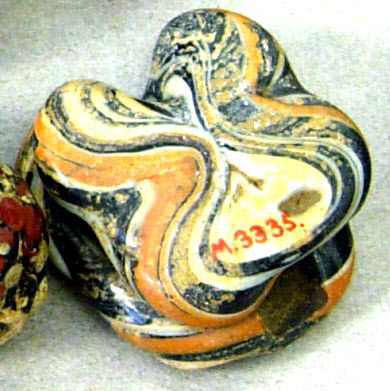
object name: bead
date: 801-1200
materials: glass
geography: egypt